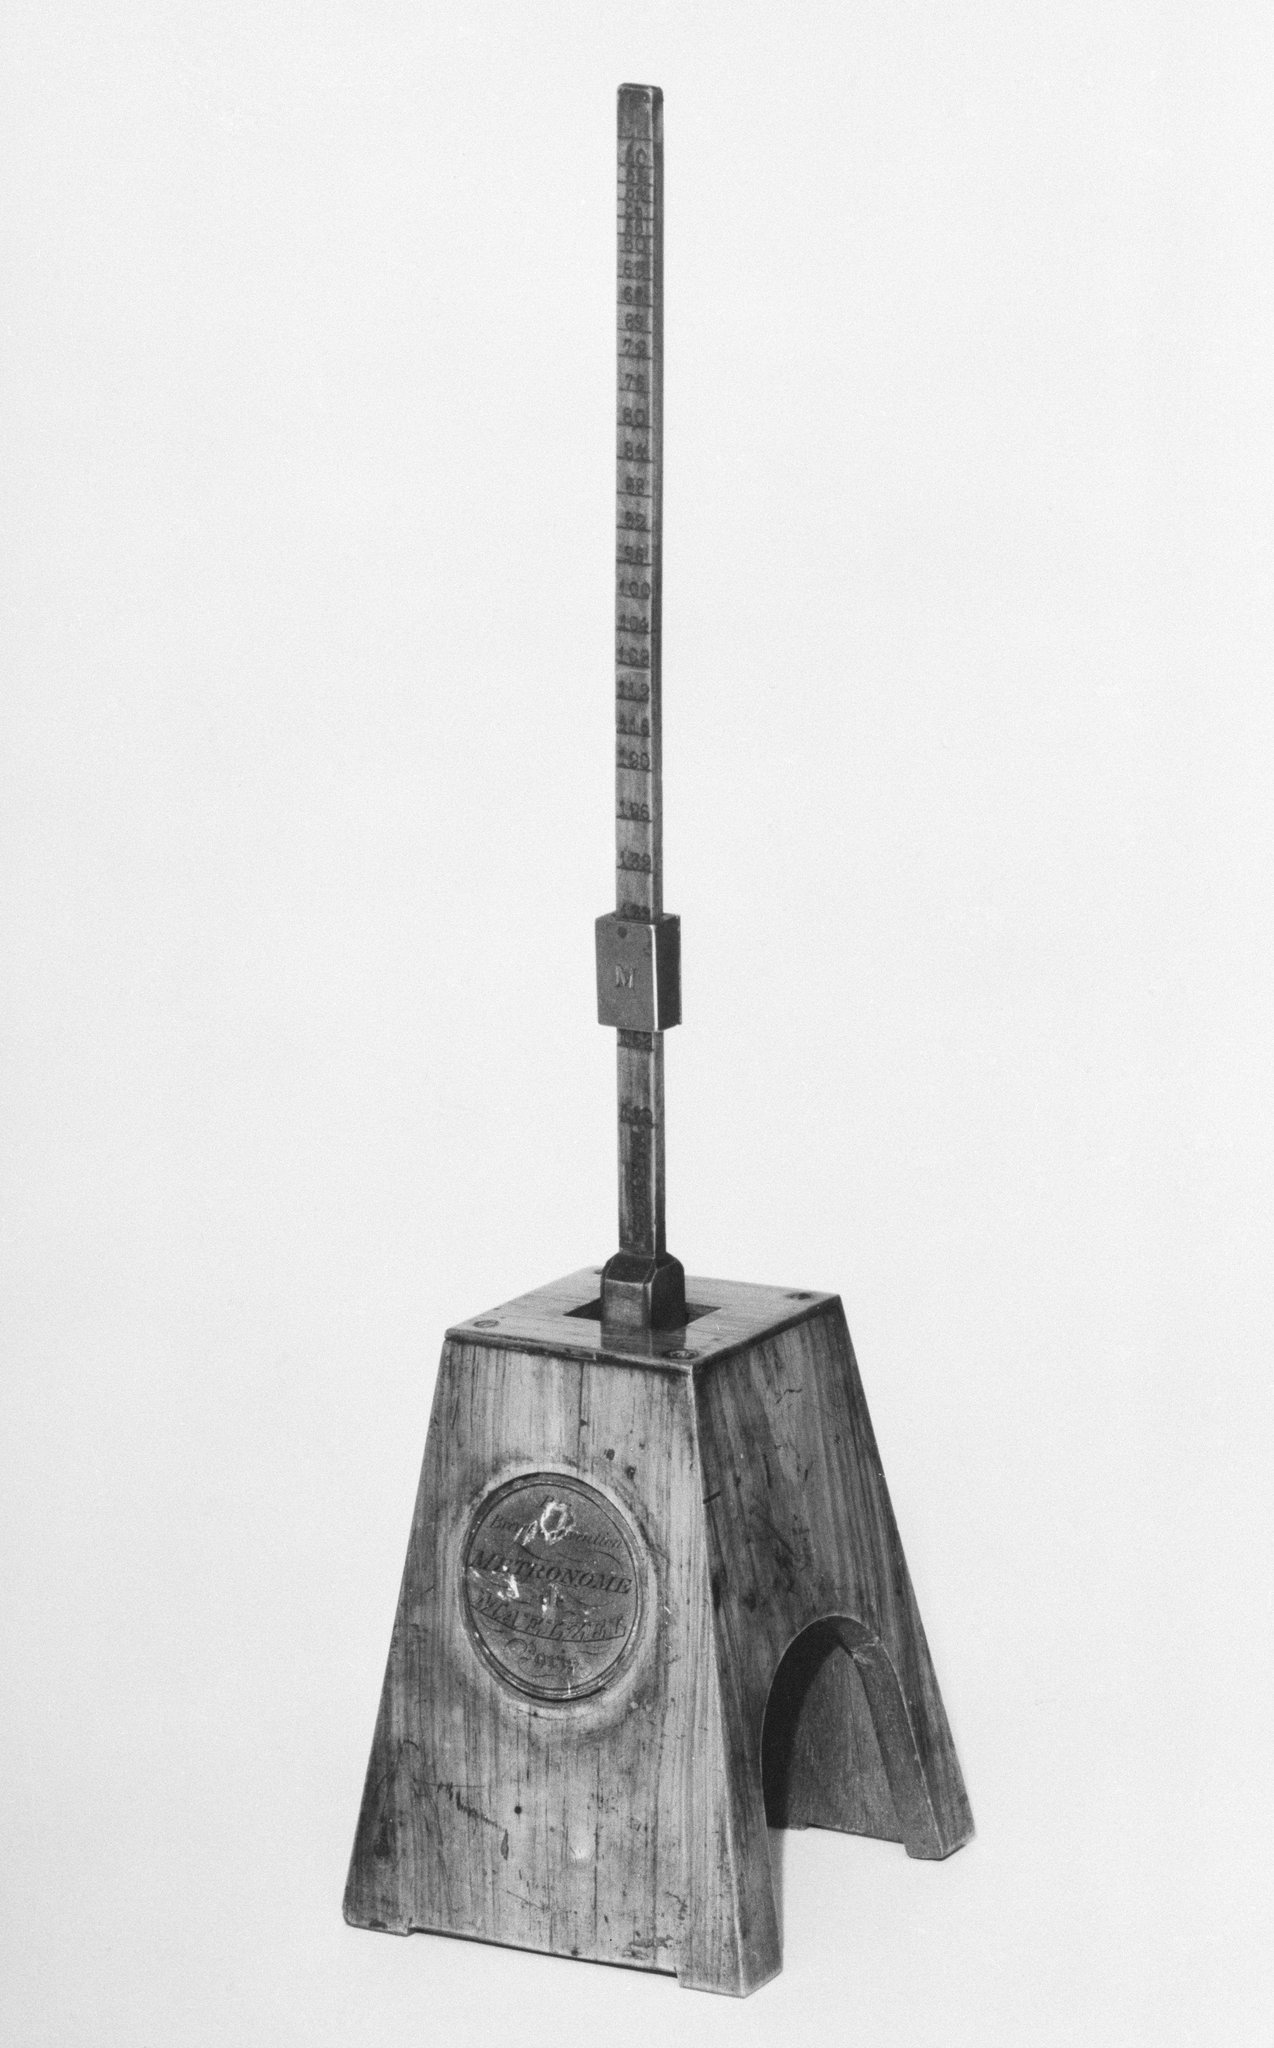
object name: metronome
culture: french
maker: johann nepomuk maelzel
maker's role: maker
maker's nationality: german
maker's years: 1772-1838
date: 1821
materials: brass, wood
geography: france